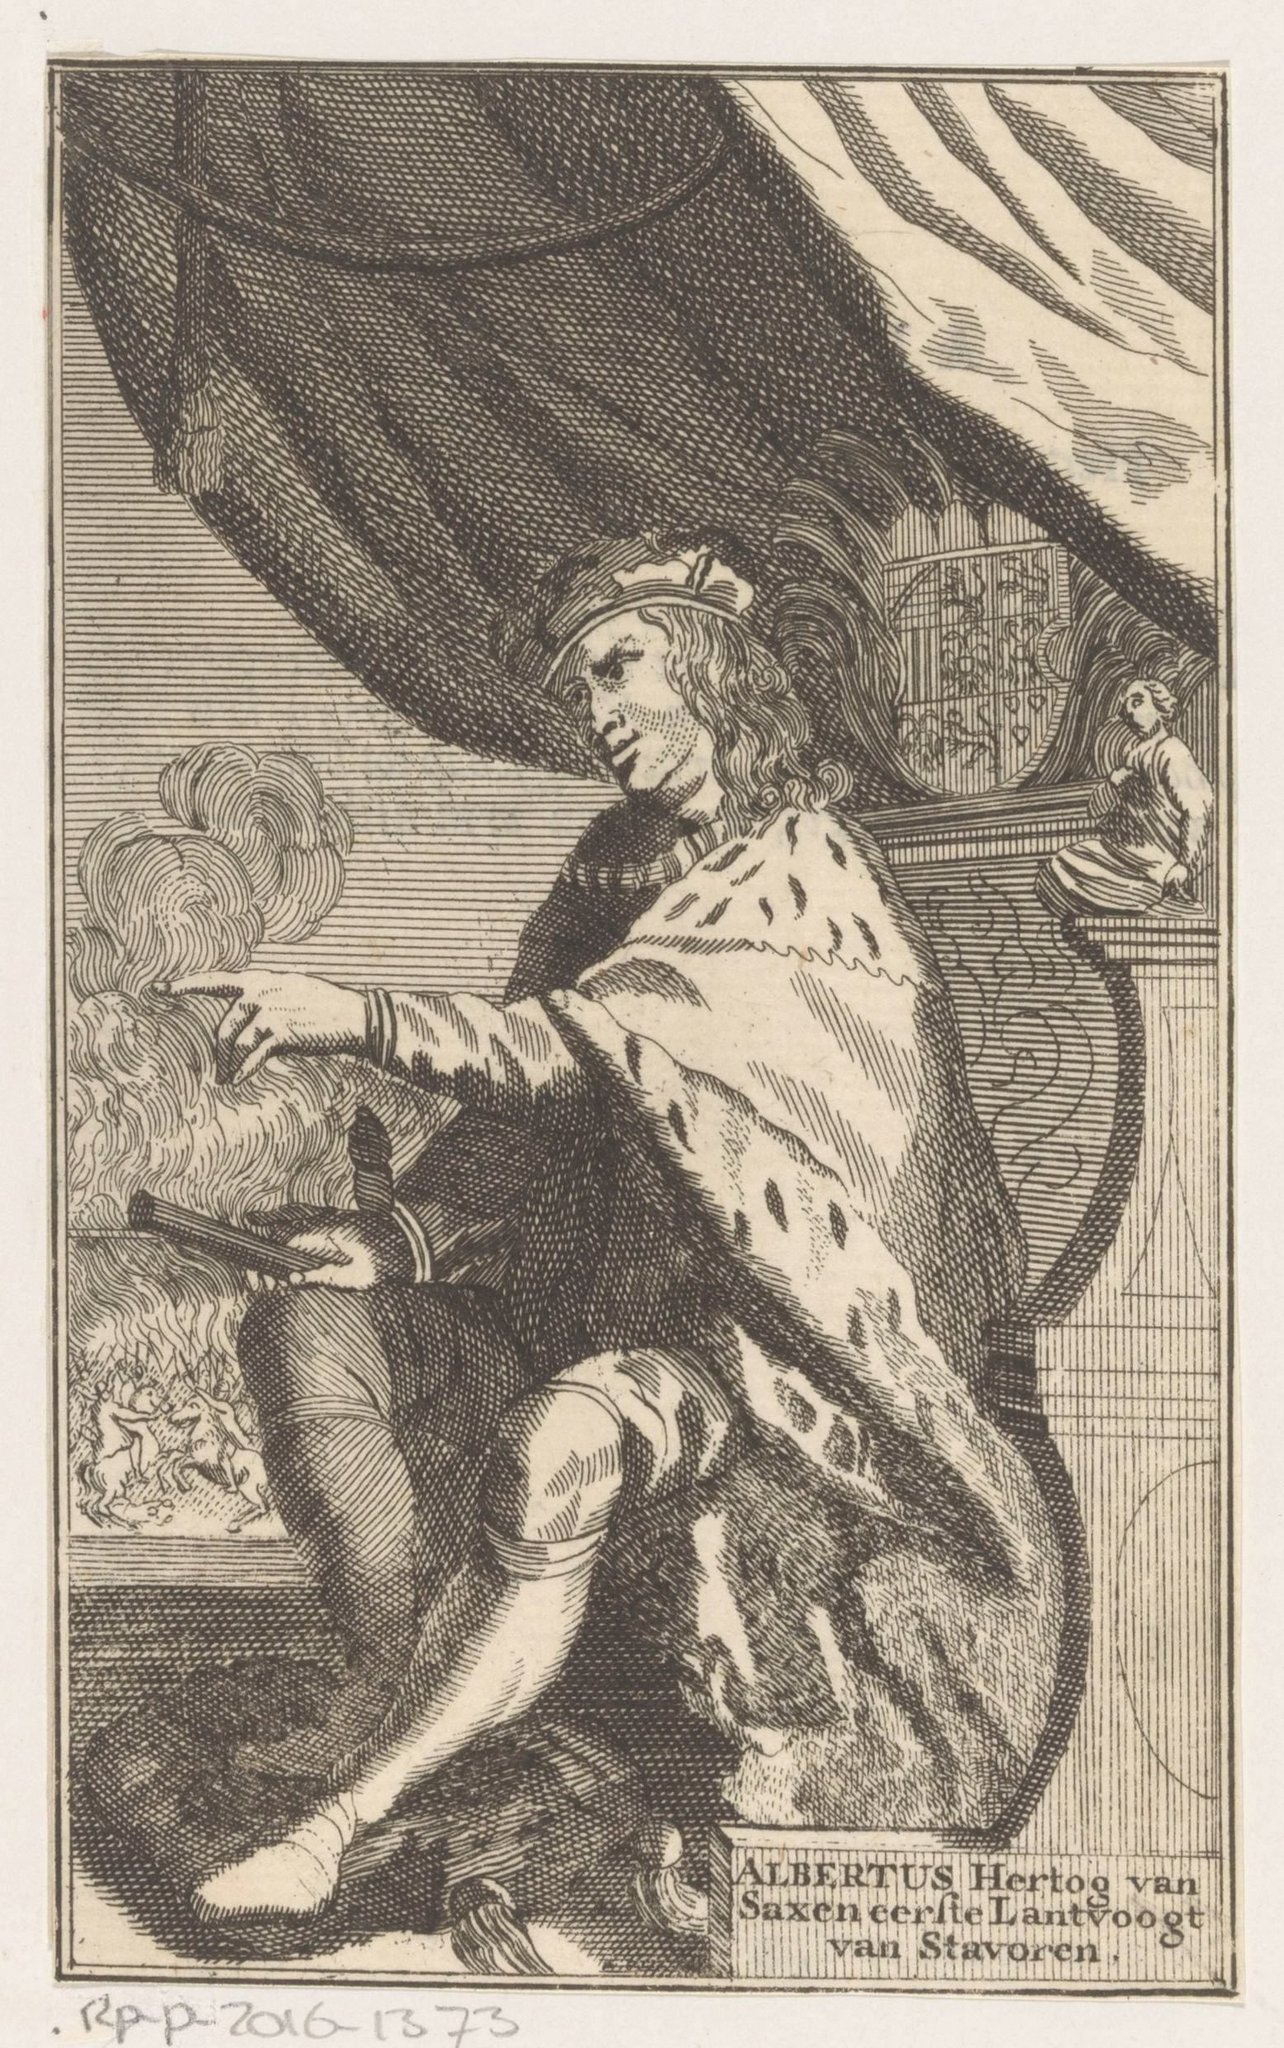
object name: book illustration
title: Portret van Albrecht III, hertog van Saksen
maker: Anonymous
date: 1600-1699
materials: paper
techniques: engraving, etching, letterpress printing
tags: grimma, emden, albrecht de kloekmoedige (hertog van saksen)